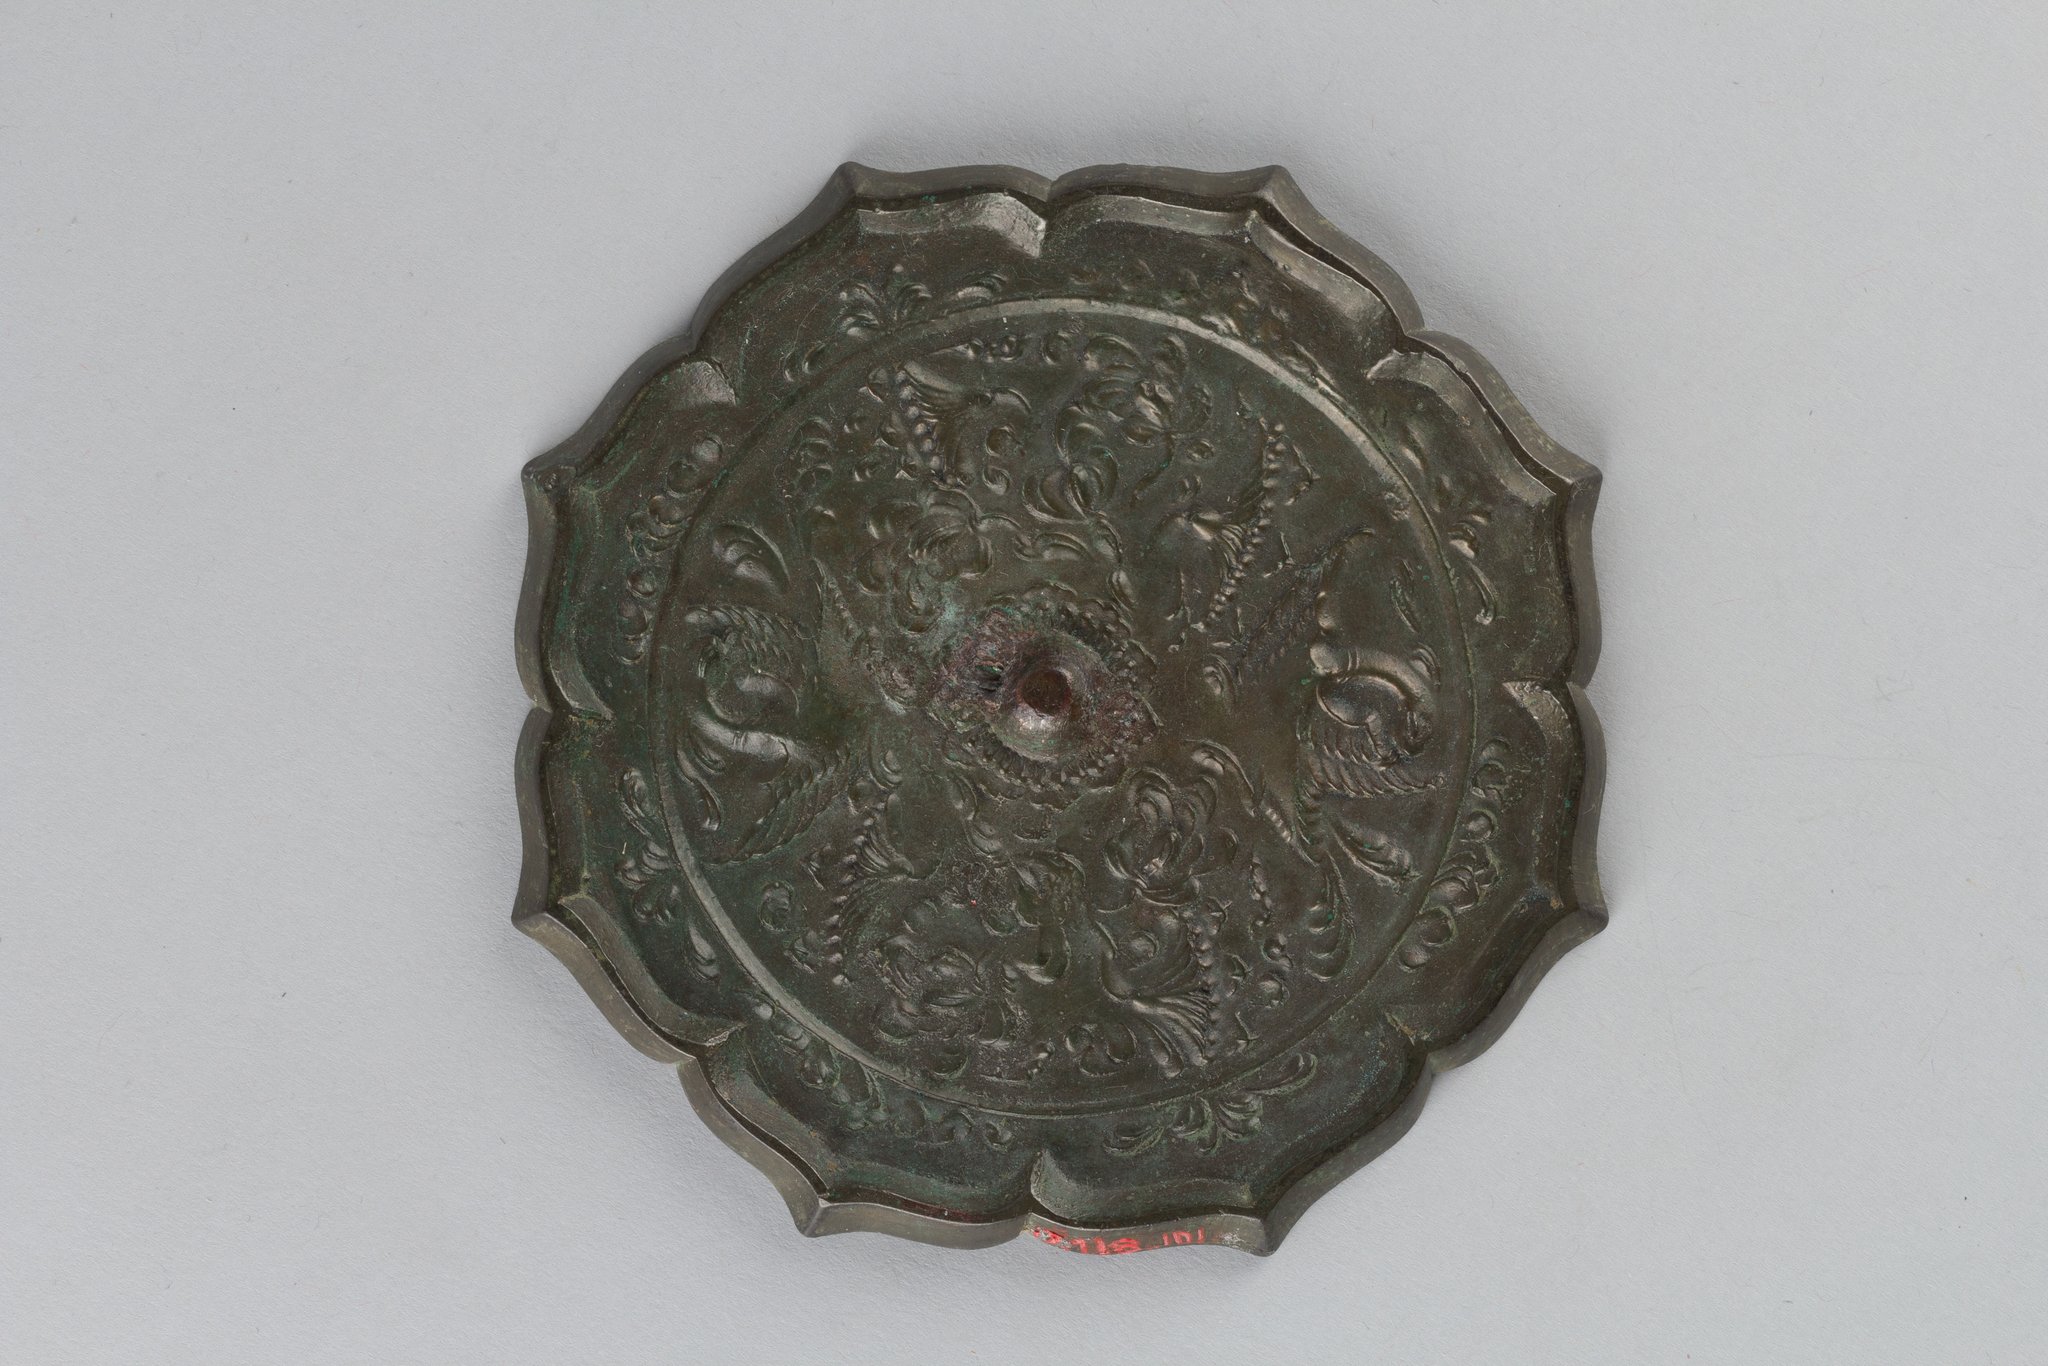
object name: mirror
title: Mirror with Decoration of Phoenix and Flowers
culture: japanese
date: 1185-1333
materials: bronze